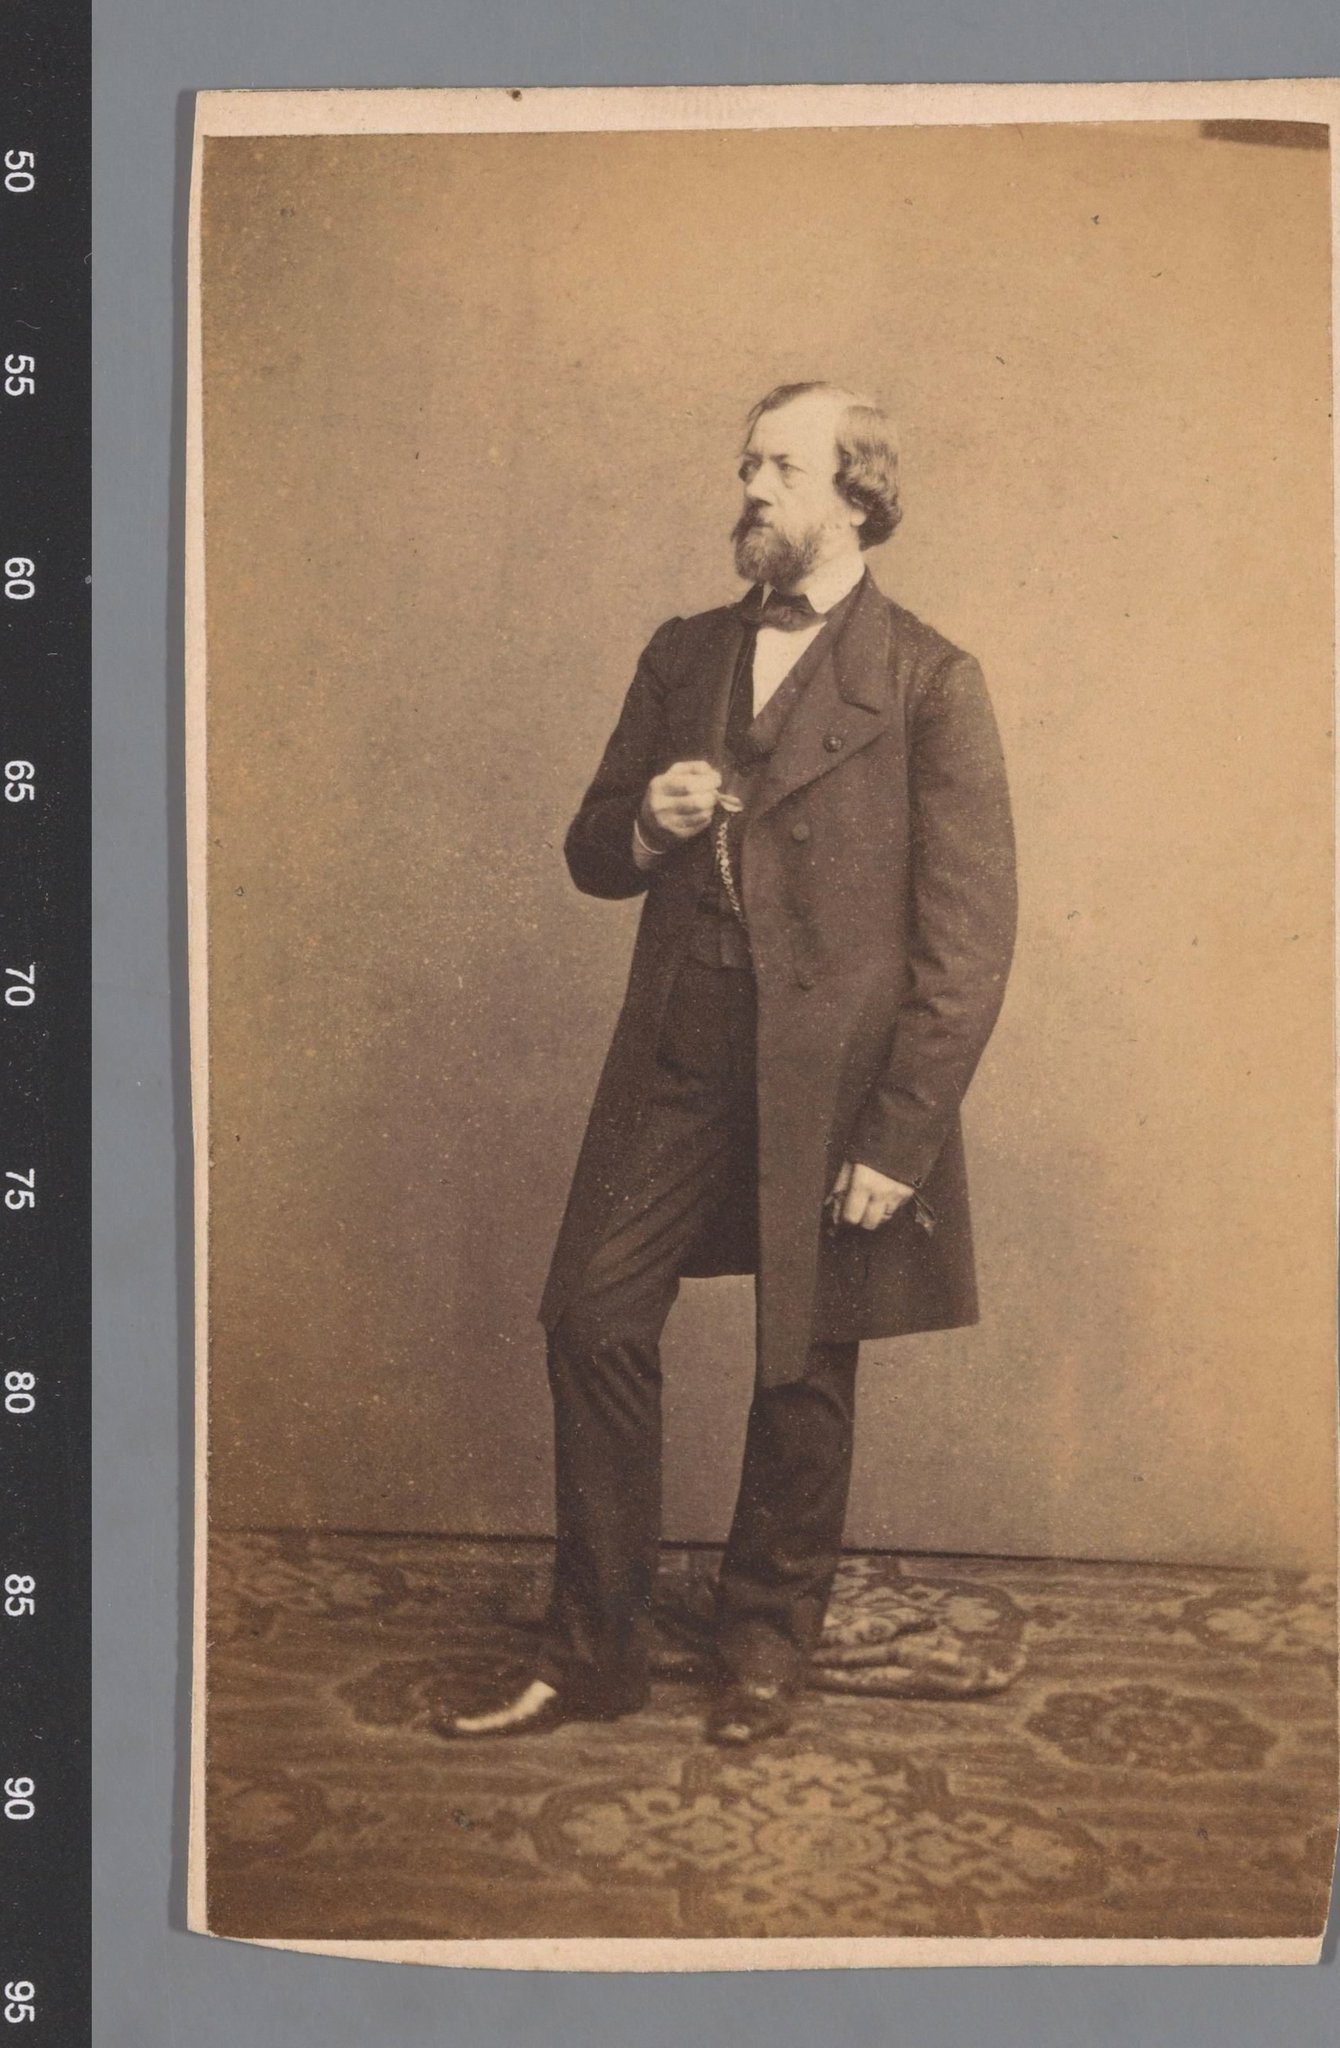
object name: photograph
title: Portret van de schilder Nicaise De Keyser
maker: joseph dupont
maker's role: fotograaf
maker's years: 1818-1901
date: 1867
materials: cardboard, photographic support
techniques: albumen print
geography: antwerp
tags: antwerp, painter, draughtsman, nicaise de keyser, historical persons, portrait, self-portrait of painter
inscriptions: annotation: ‘N. De Keyser/ (peinte)/ ancien Directeur de l'Académie/ 1867.’, inscription: ‘Etablissement Photographique/ DE/ J. DUPONT,/ Place de Meir, 32,/ Anvers./ Maison fondée en 1853.’, annotation: ‘Nicaise/ santvliet 1813’